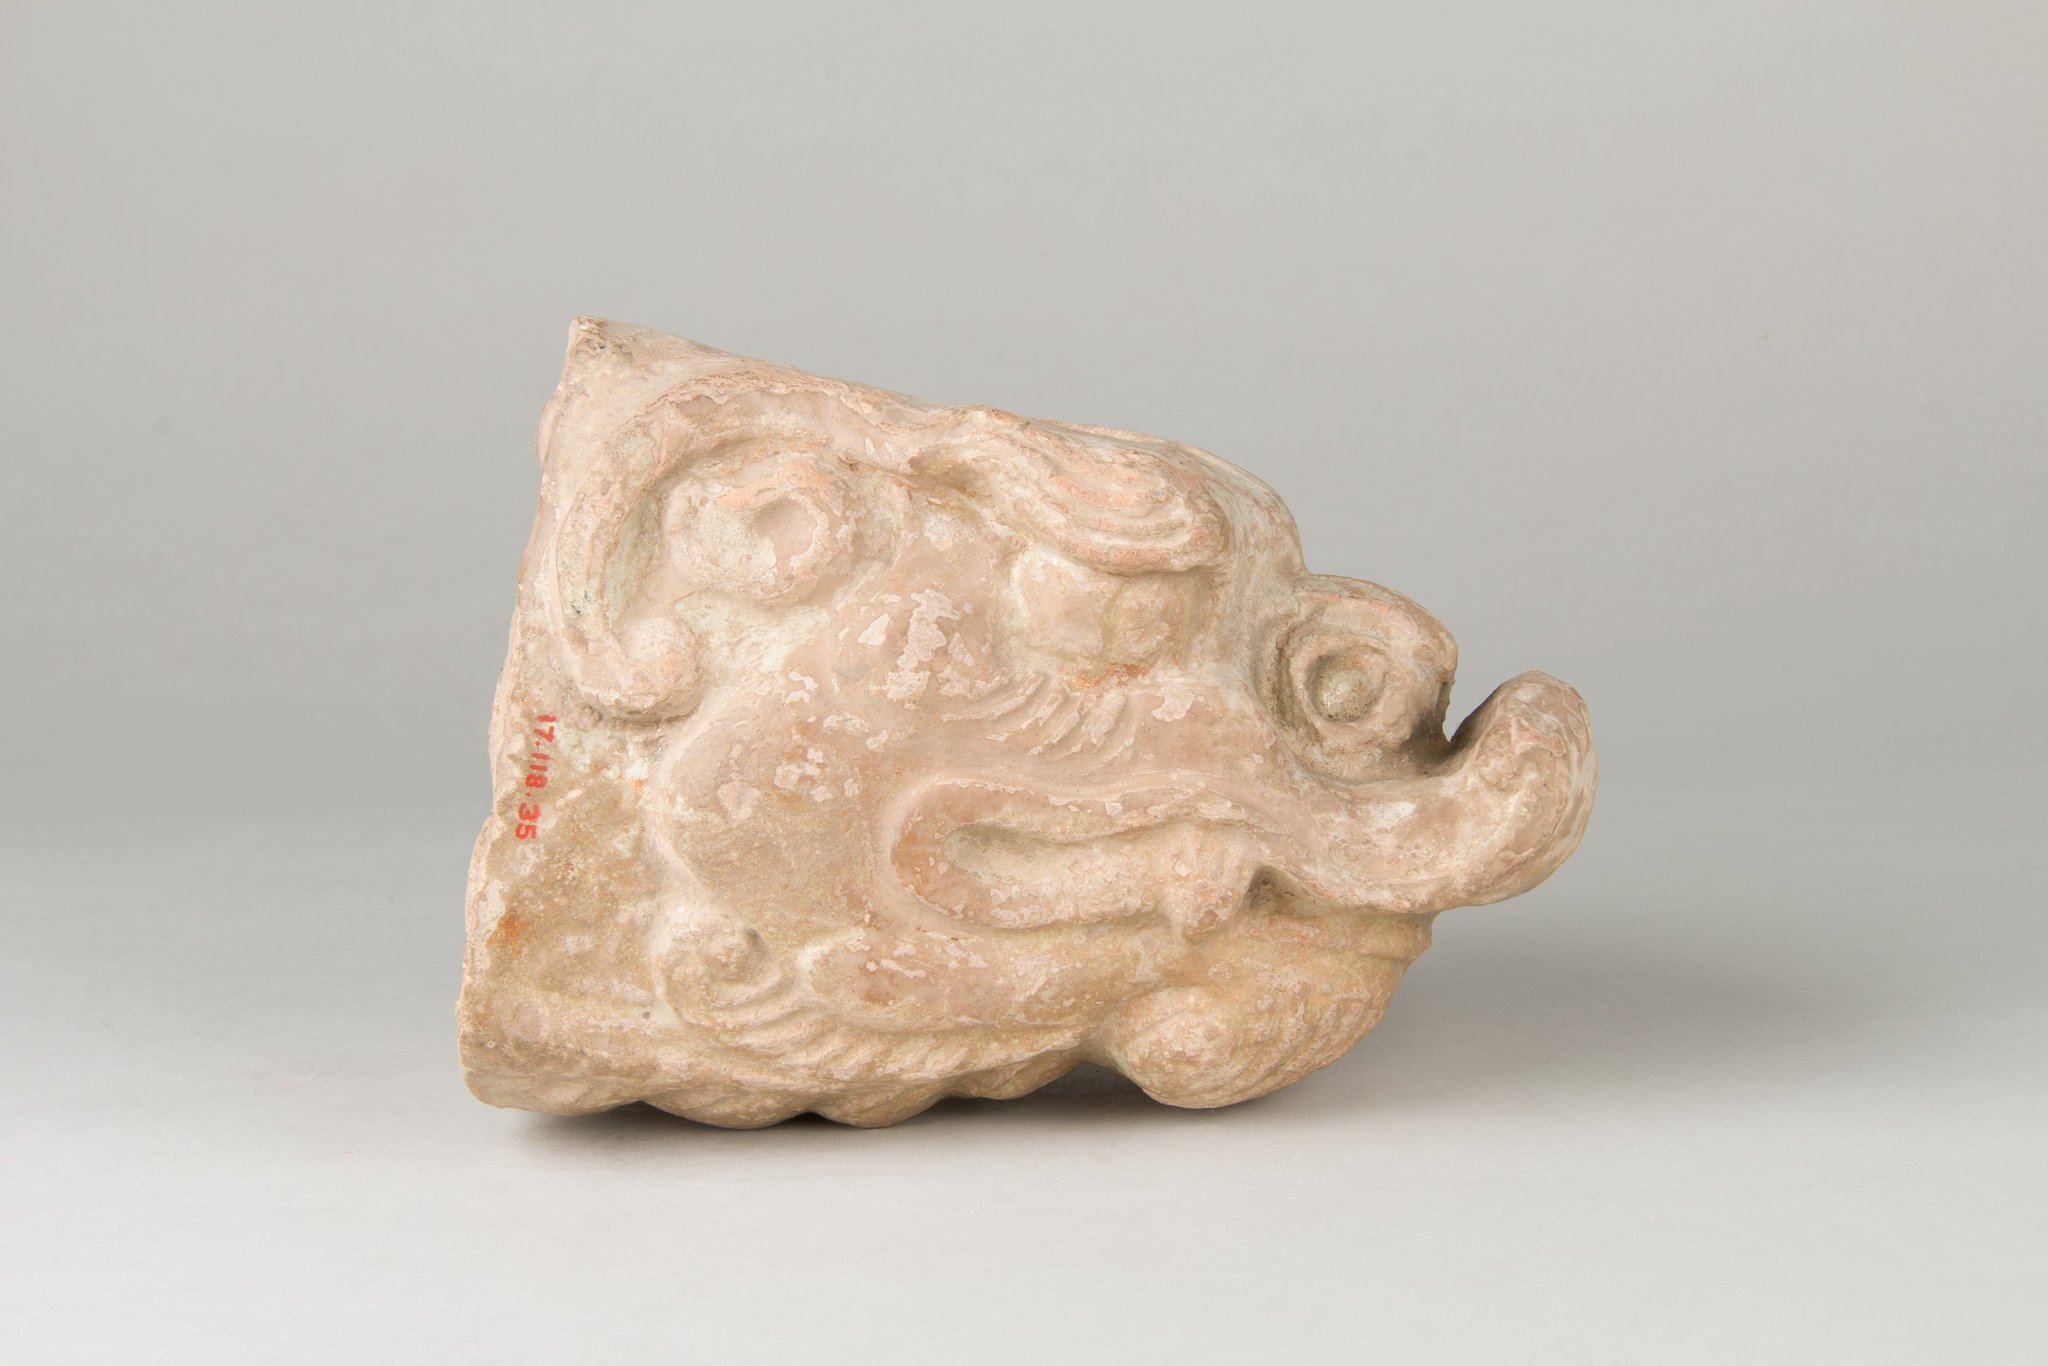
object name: figure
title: Dragon head (Architectural part)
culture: chinese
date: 618-907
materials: earthenware